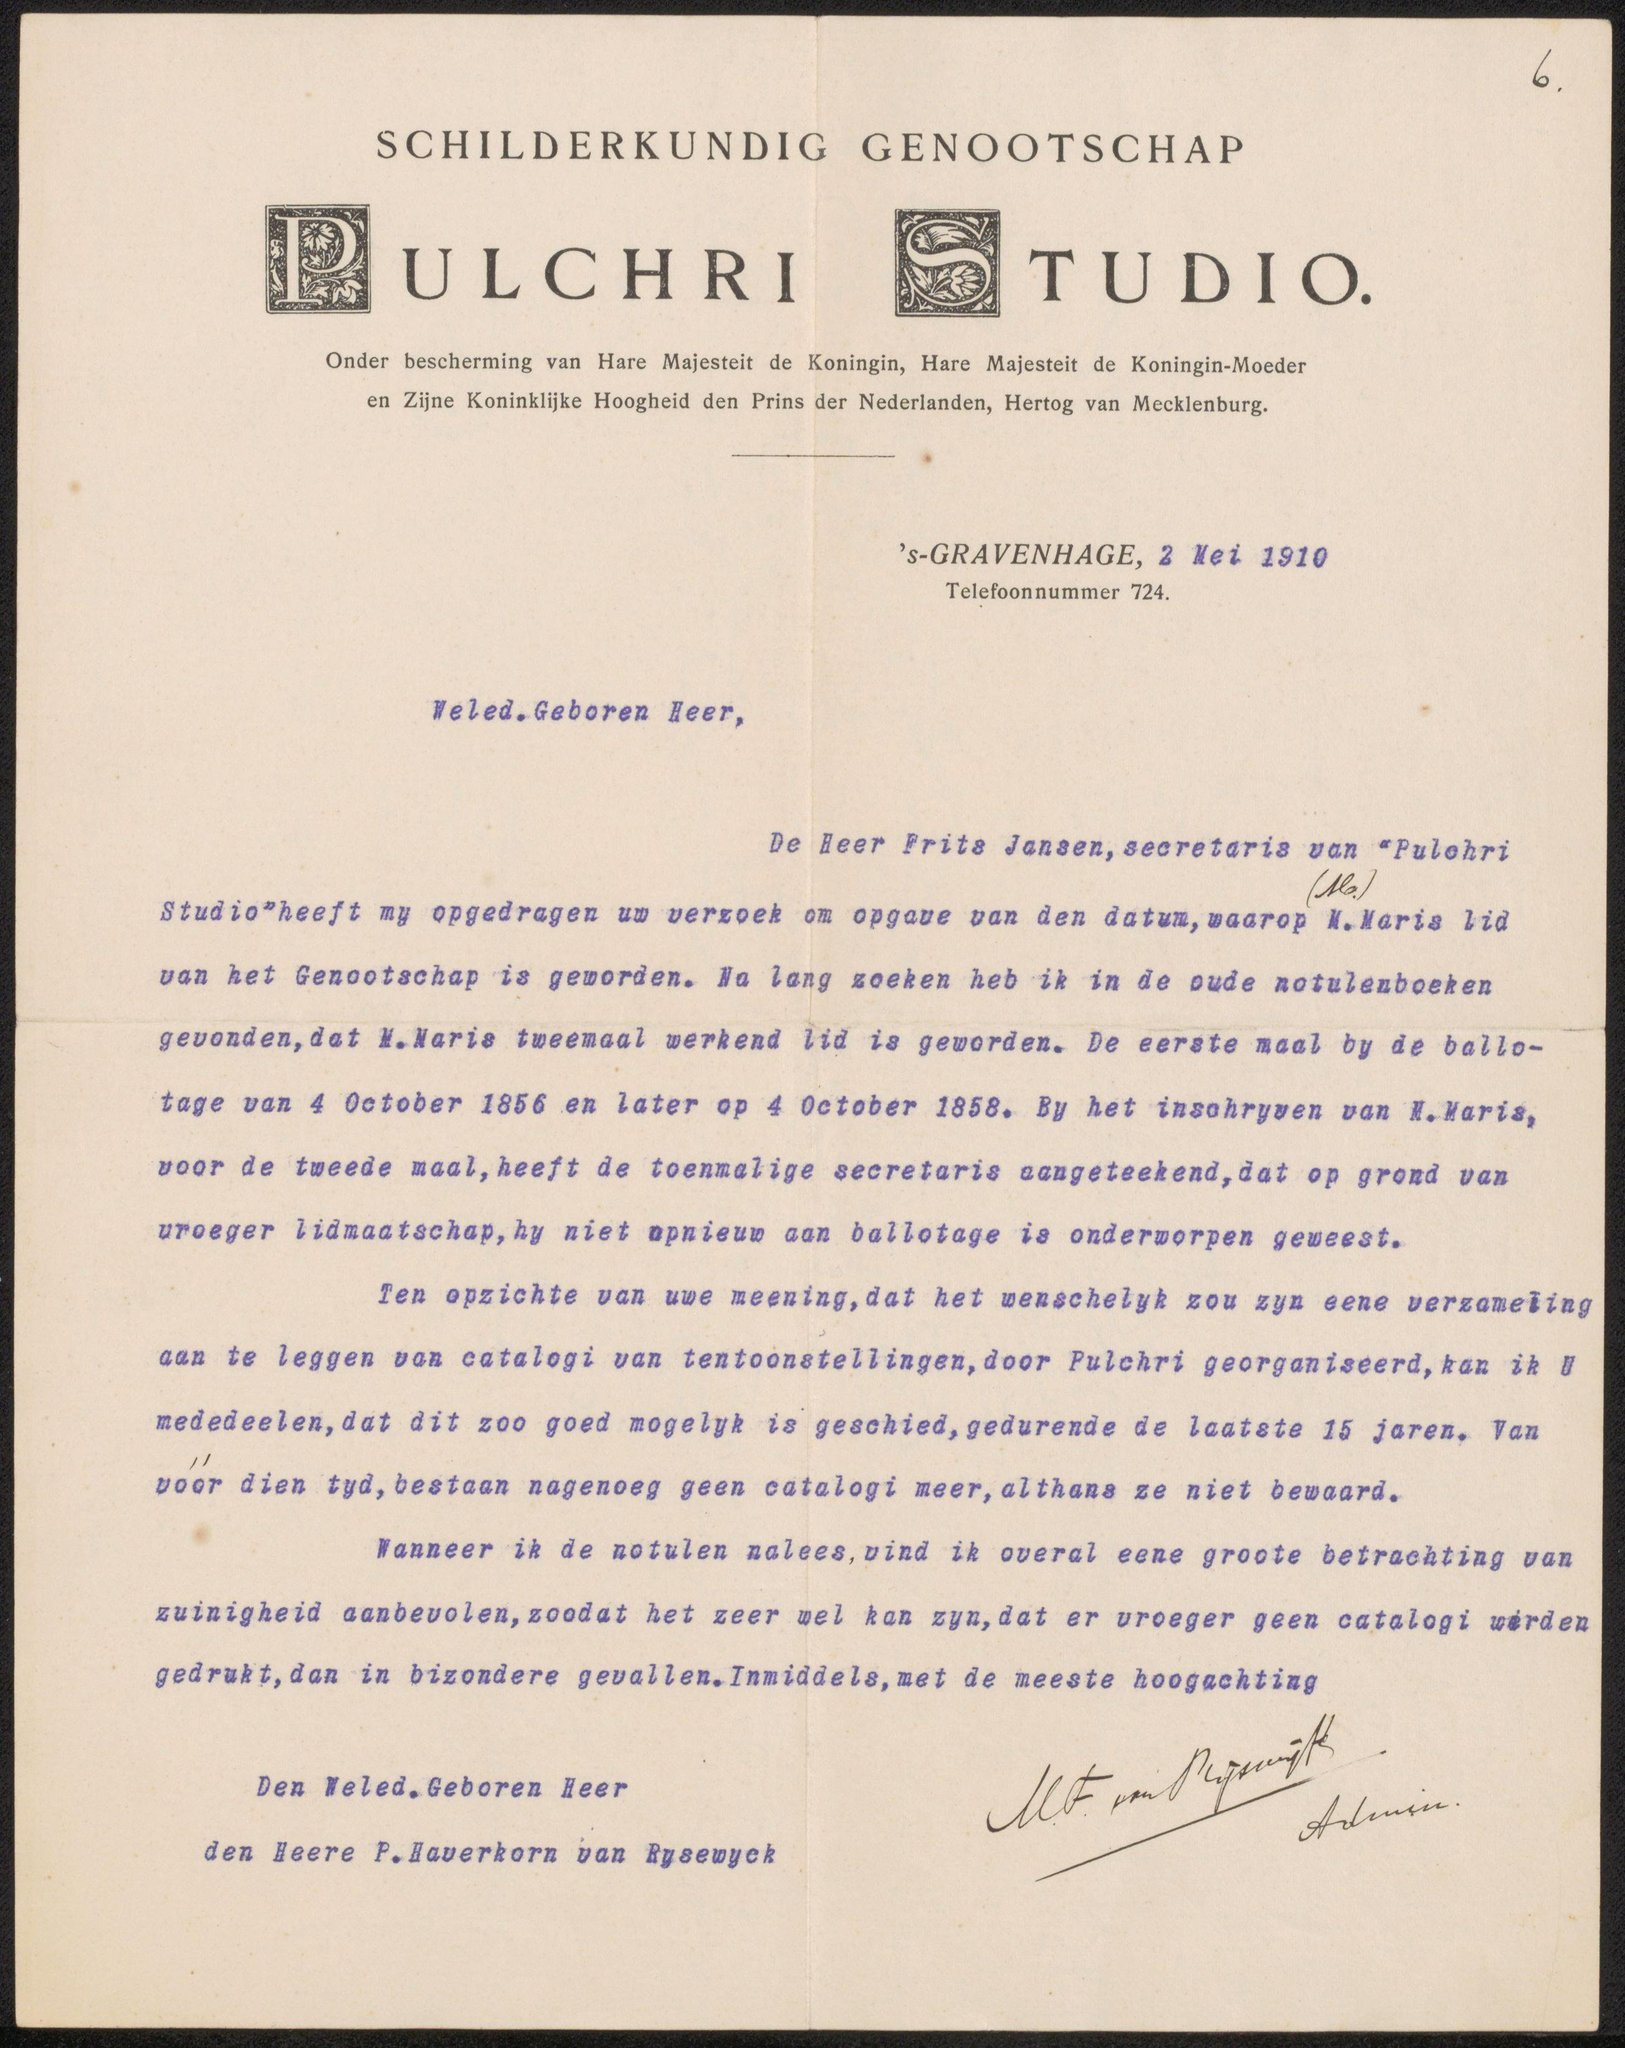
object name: letter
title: Brief aan Pieter Haverkorn van Rijsewijk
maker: m.f. van rijswijk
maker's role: schrijver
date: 1910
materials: ink, paper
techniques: pen, printing, typewriting, writing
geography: the hague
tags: the hague, london, painter, print maker, draughtsman, matthijs maris, pieter haverkorn van rijsewijk, exhibition ~ art, printed matter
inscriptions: watermark